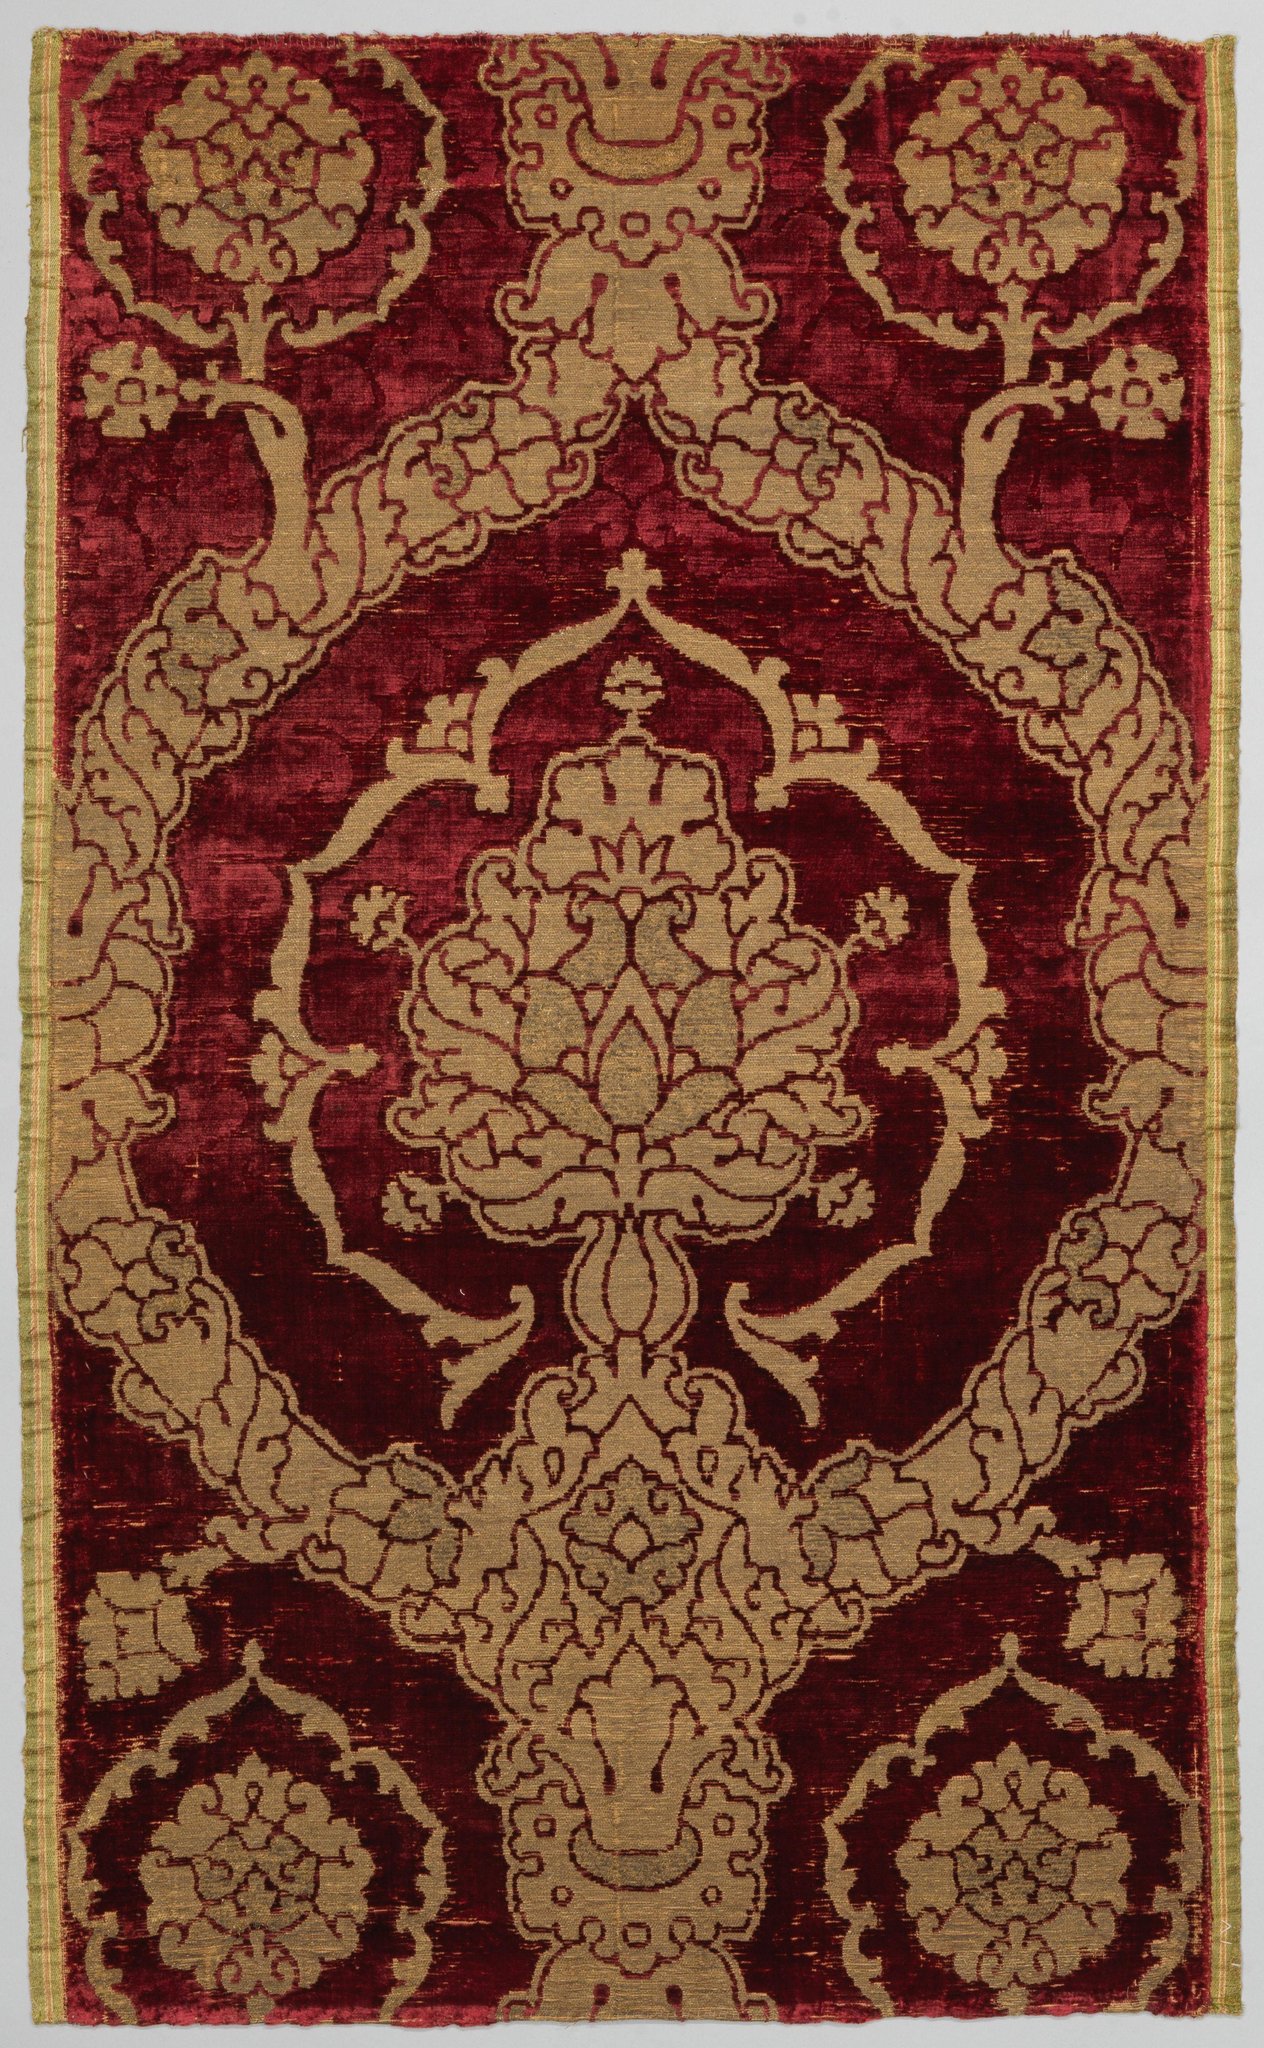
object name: baan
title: Baan geschoren fluweel met granaatappelmotief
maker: Anonymous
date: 1500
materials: metal, silk, velvet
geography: italy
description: Baan geschoren rood fluweel oop een grondweefsel van kettingsatijn (?) van een metalen ketting en geel zijden inslag, plaatselijk voorzien van metalen lusjes. Dessin: spitsovaal, waarbinnen vijflobbige rozet met granaatappelmotief. Uit de brede ranken die de granaatappels omgeven, ontspringen boven en beneden, telkens twee elkaar tegenovergestelde kleinere granaatappels; de ranken zijn in het midden ingesnoerd. Toestand: redelijk/goed. Opmerking: Vgl.: Dreger Band Tafeln 1 no. 147 text. p. 158-172 voor vergelijkbaar stuk in Museum fur Kunst und Industrie, Wenen.